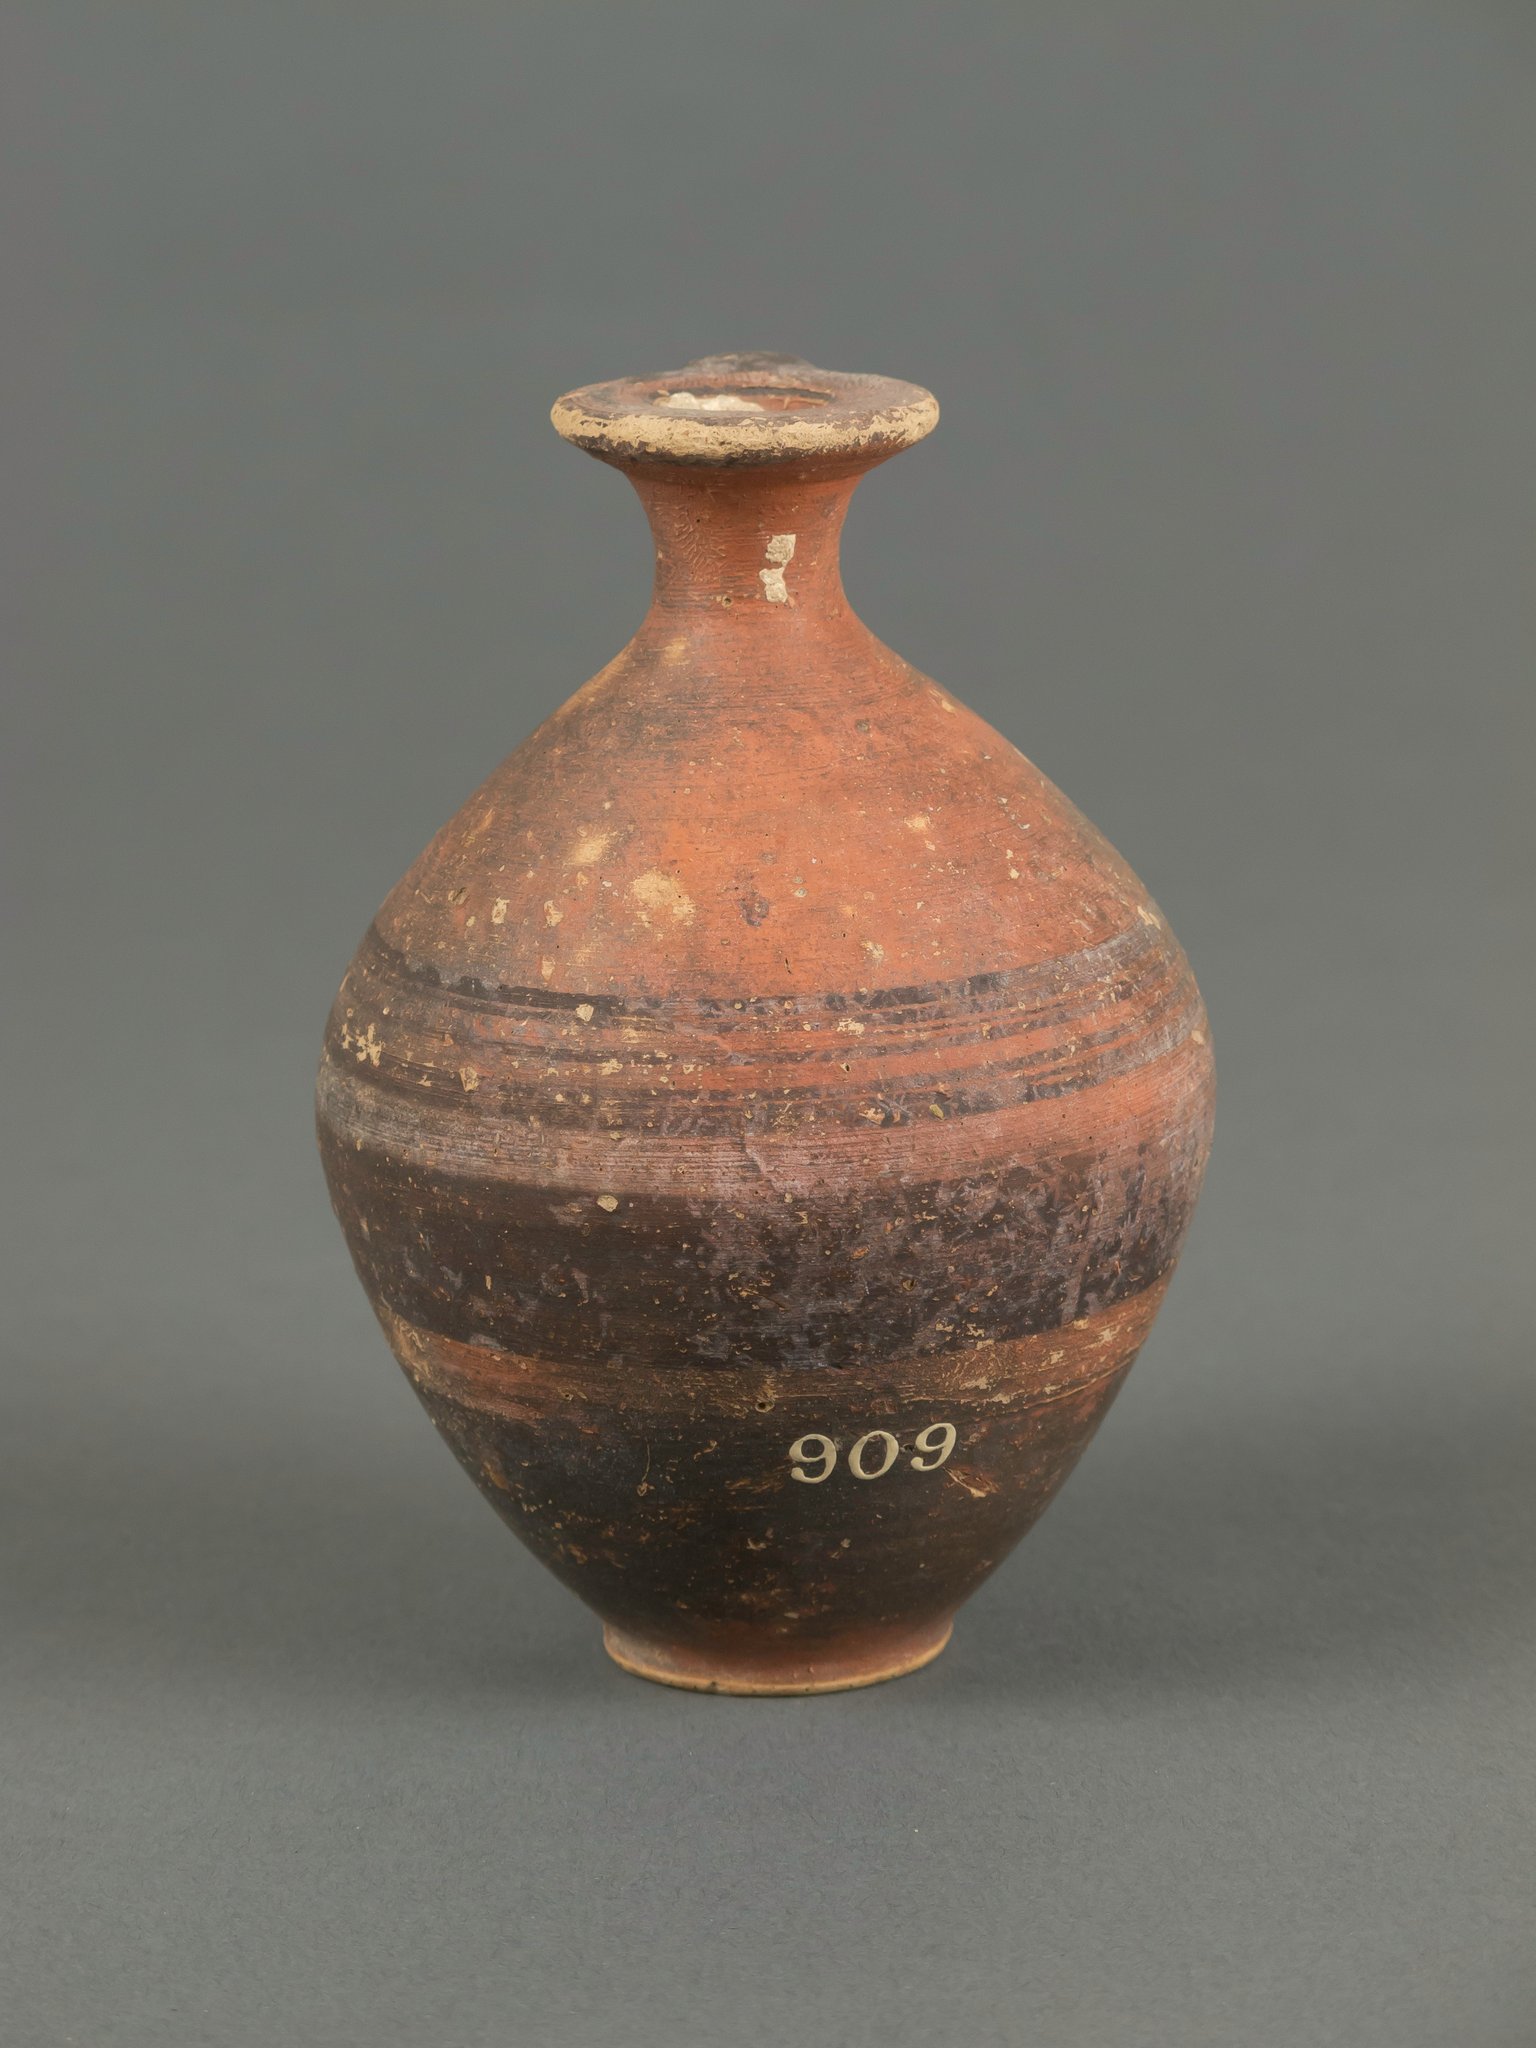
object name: jug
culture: cypriot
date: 507-323 BCE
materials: terracotta